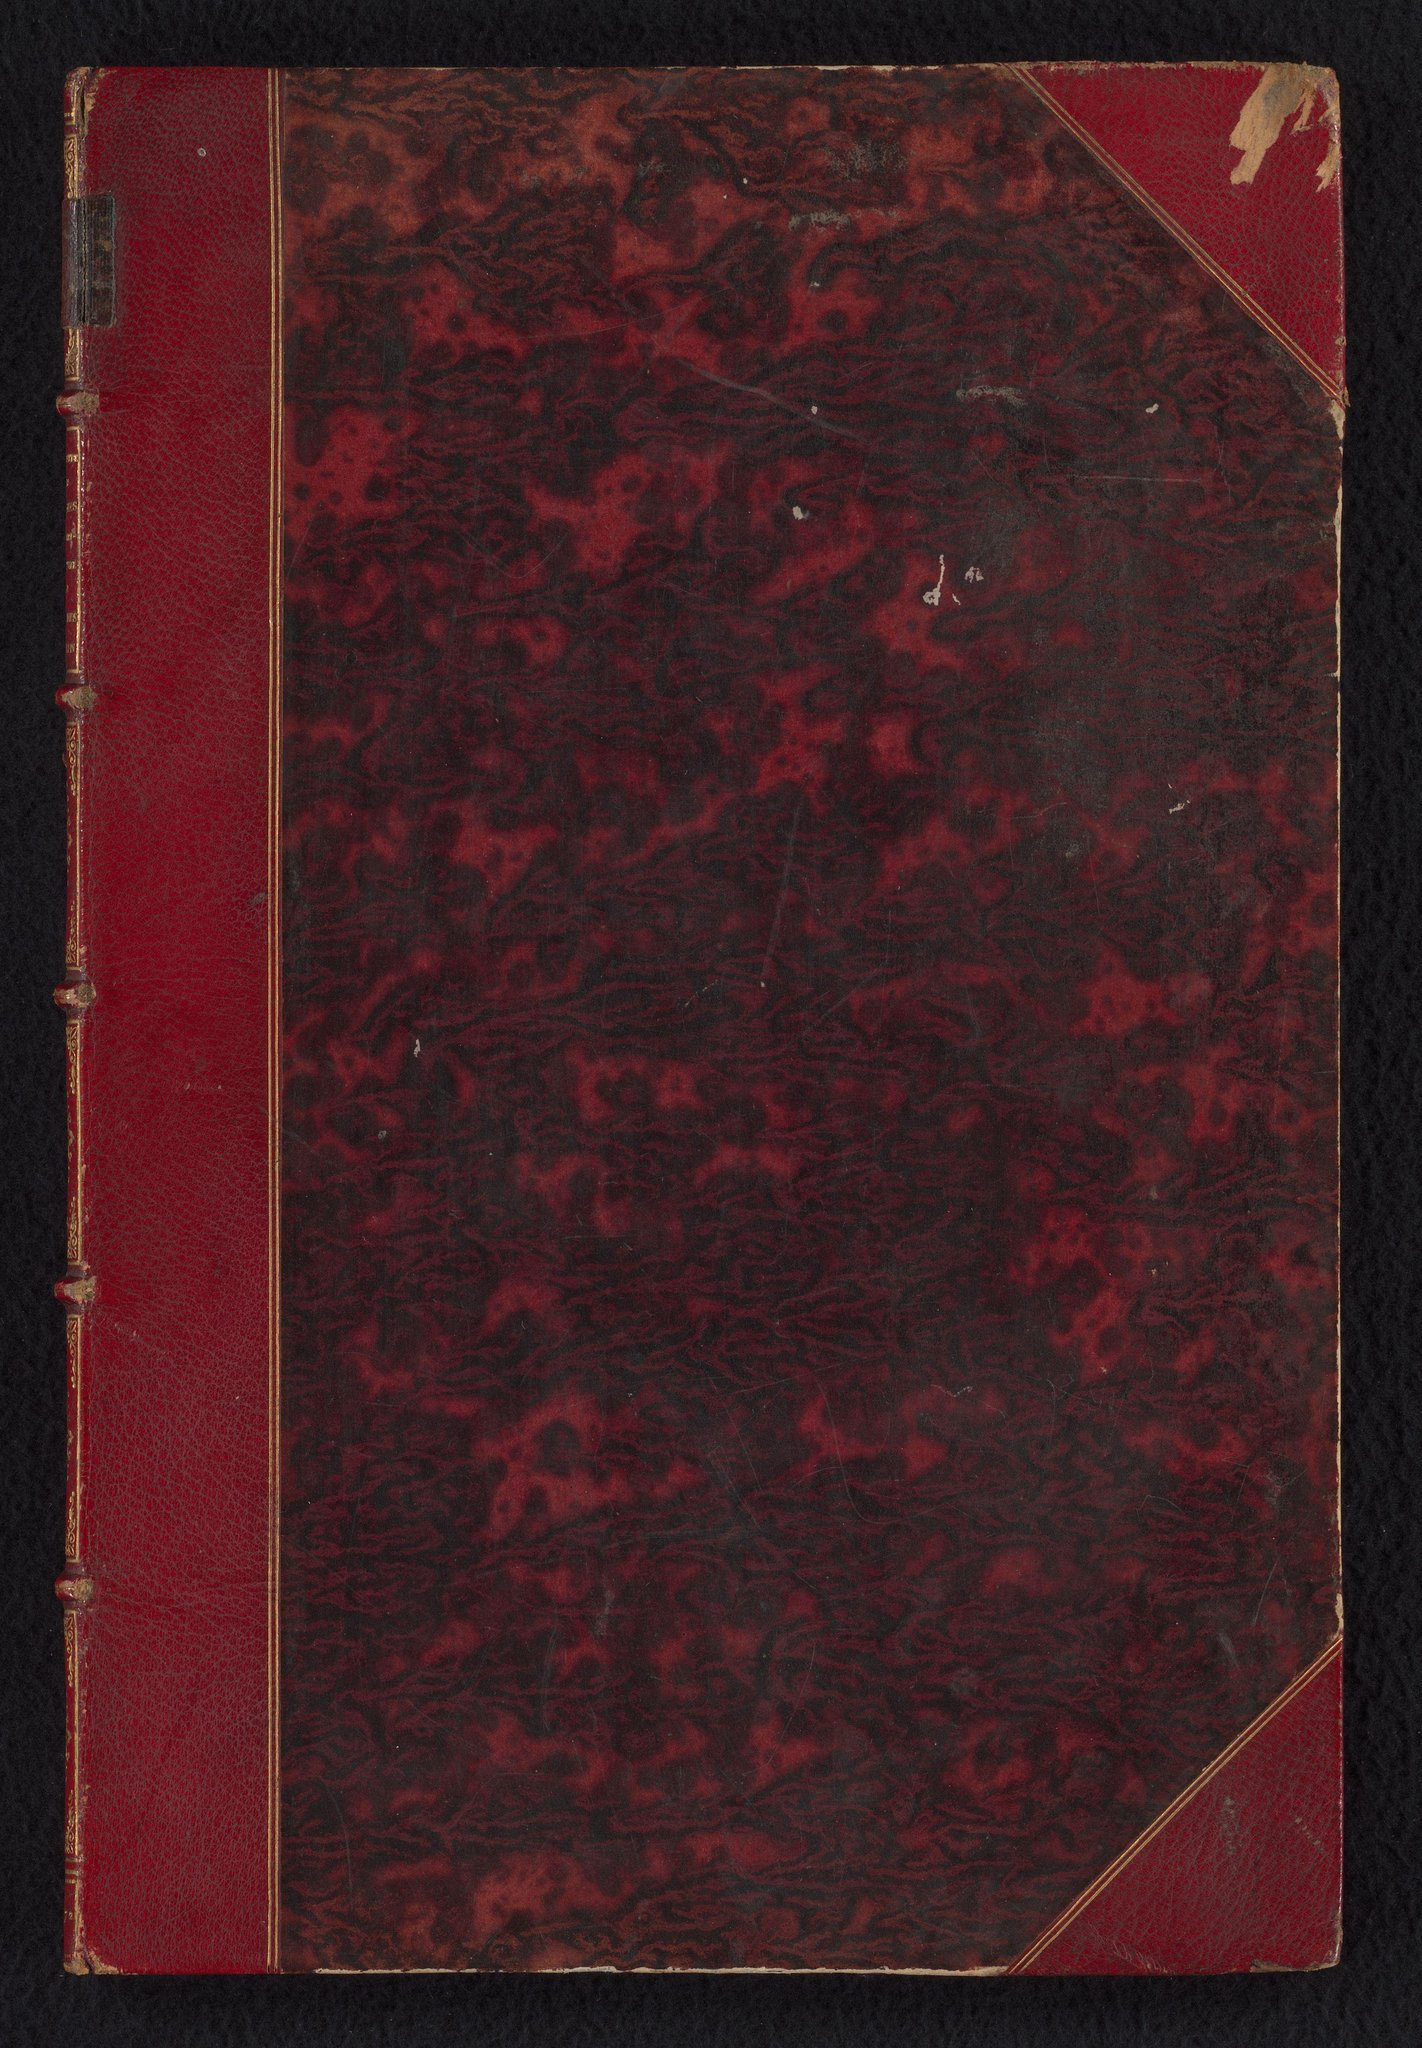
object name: prentrecueil, prentenalbum, prentalbum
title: Album met termen in verschillende architectonische orden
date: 1572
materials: cardboard, leather, paper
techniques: bookbinding, marbled paper, letterpress printing, marbling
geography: lyon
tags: herms (garden ornaments), pedestal of a piece of sculpture (perhaps in the form of a herm), herm: pillar with the head of mercury, patron of travellers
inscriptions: inscription: ‘Oeuvre de la diversité des thermes/ Ces figures sont dessinées dans le grand et/ [...]ombre caractère dont Michel Ange a/ donné de si remarquables exemples. On disait/ à Lyon (...)’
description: Bij de Special Collections van het Rijksmuseum bevindt zich nog een exemplaar van deze uitgave. Wie de houtsnedes heeft gemaakt is onzeker: in zijn publicatie over houtsnedes zou Jean-Michel Papillon ze aan Bernard Salomon toegeschreven hebben, op basis van de engel bij de tiende term die een letter S op een schild schrijft. In 'Bernard Salomon: illustrateur lyonnais' van Peter Sharratt wordt dit verworpen en wordt de prentserie uitgesloten van Salomons oeuvre. De engel met de S verwijst logischerwijs eerder naar Hugues Sambin als ontwerper.